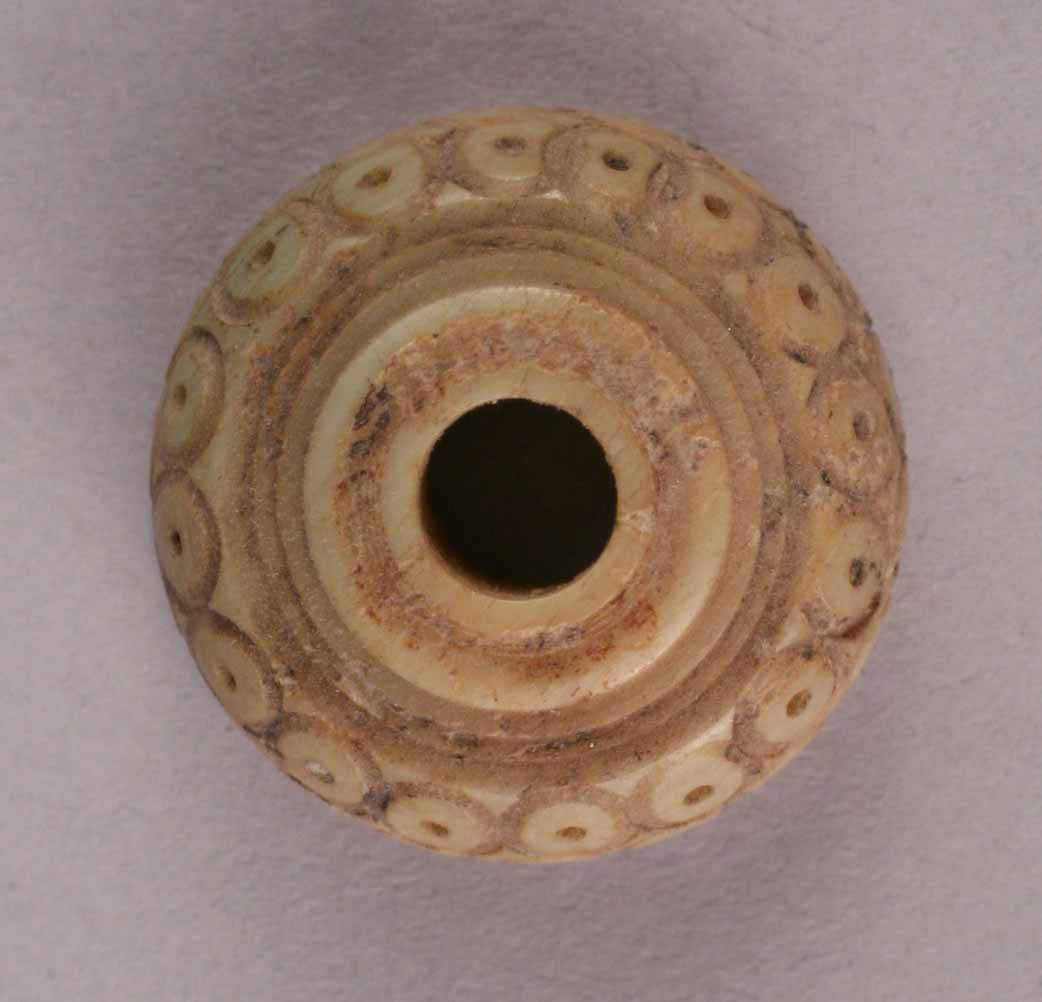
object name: button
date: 801-1000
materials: bone, paint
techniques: incising, inlay, tinting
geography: iran